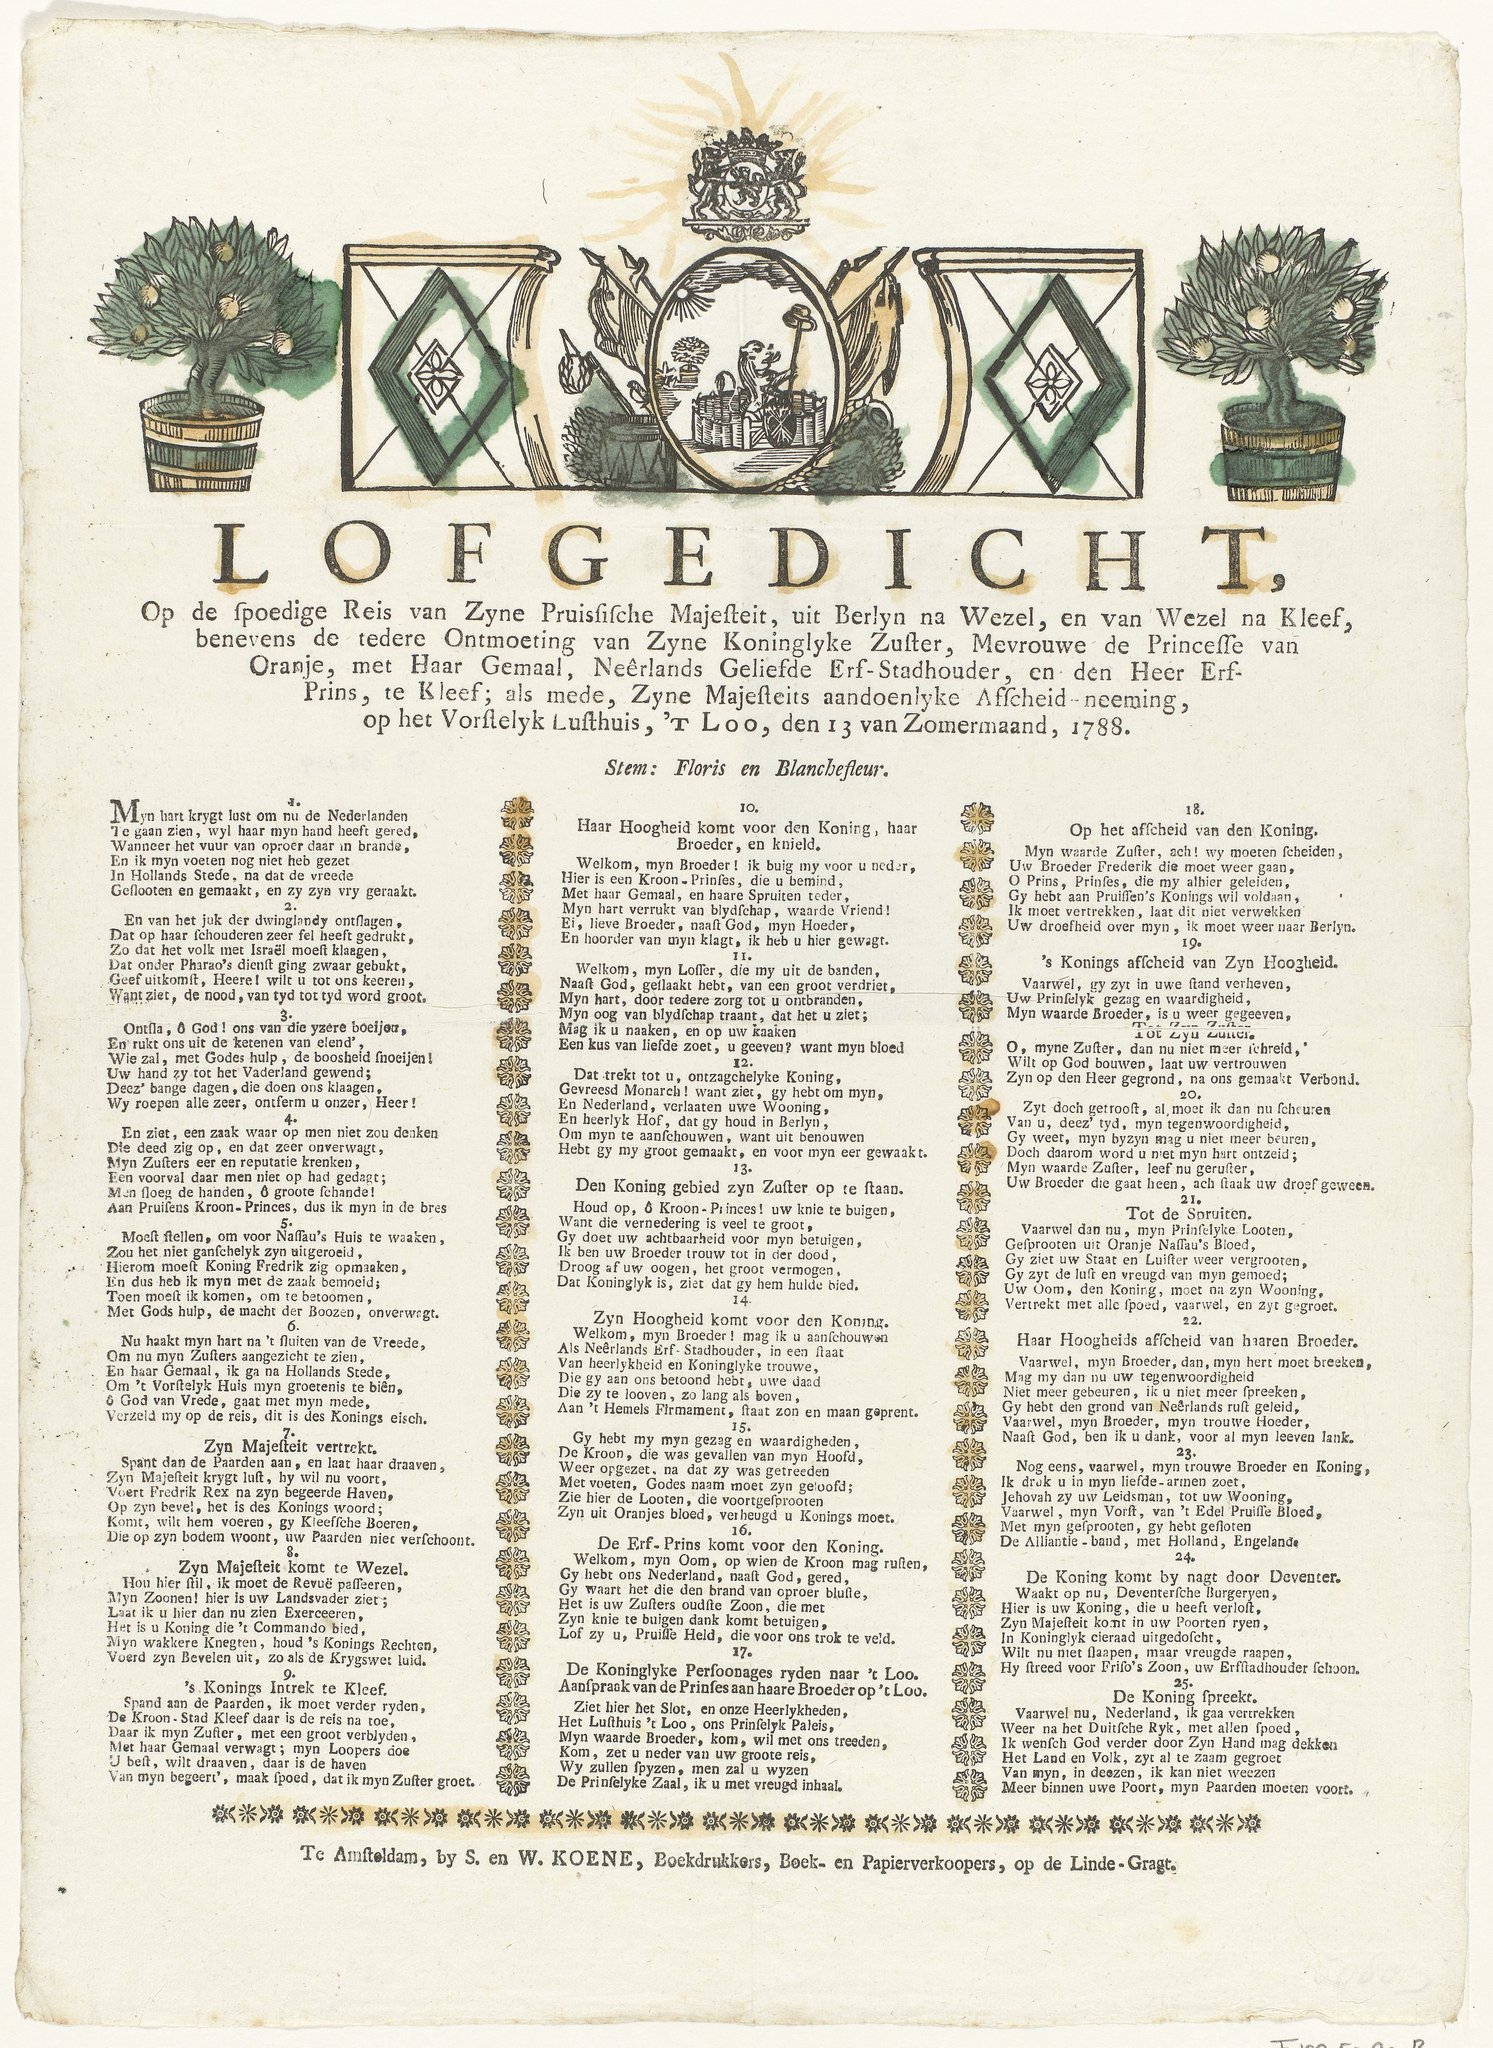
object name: print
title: Lofvers op de reis van koning Frederik Willem II naar Kleef om zijn zuster te ontmoeten en op het afscheid, 1788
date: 1788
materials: paper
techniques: letterpress printing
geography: amsterdam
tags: william v (prince of orange), frederik willem ii (koning van pruisen), berlin, painter, wilhelmina of prussia (princess of orange), cleves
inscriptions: collector's mark: Lugt 2228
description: Lofvers op de reis van koning Frederik Willem II van Pruisen naar Kleef om zijn zuster de prinses Wilhelmina van Pruisen te ontmoeten en op het afscheid van zijn zuster en haar kinderen op Paleis het Loo, 13 juli 1788. Vers in 25 coupletten in drie kolommen. Bovenaan een vignet met de Hollandse leeuw tussen Oranjebomen.